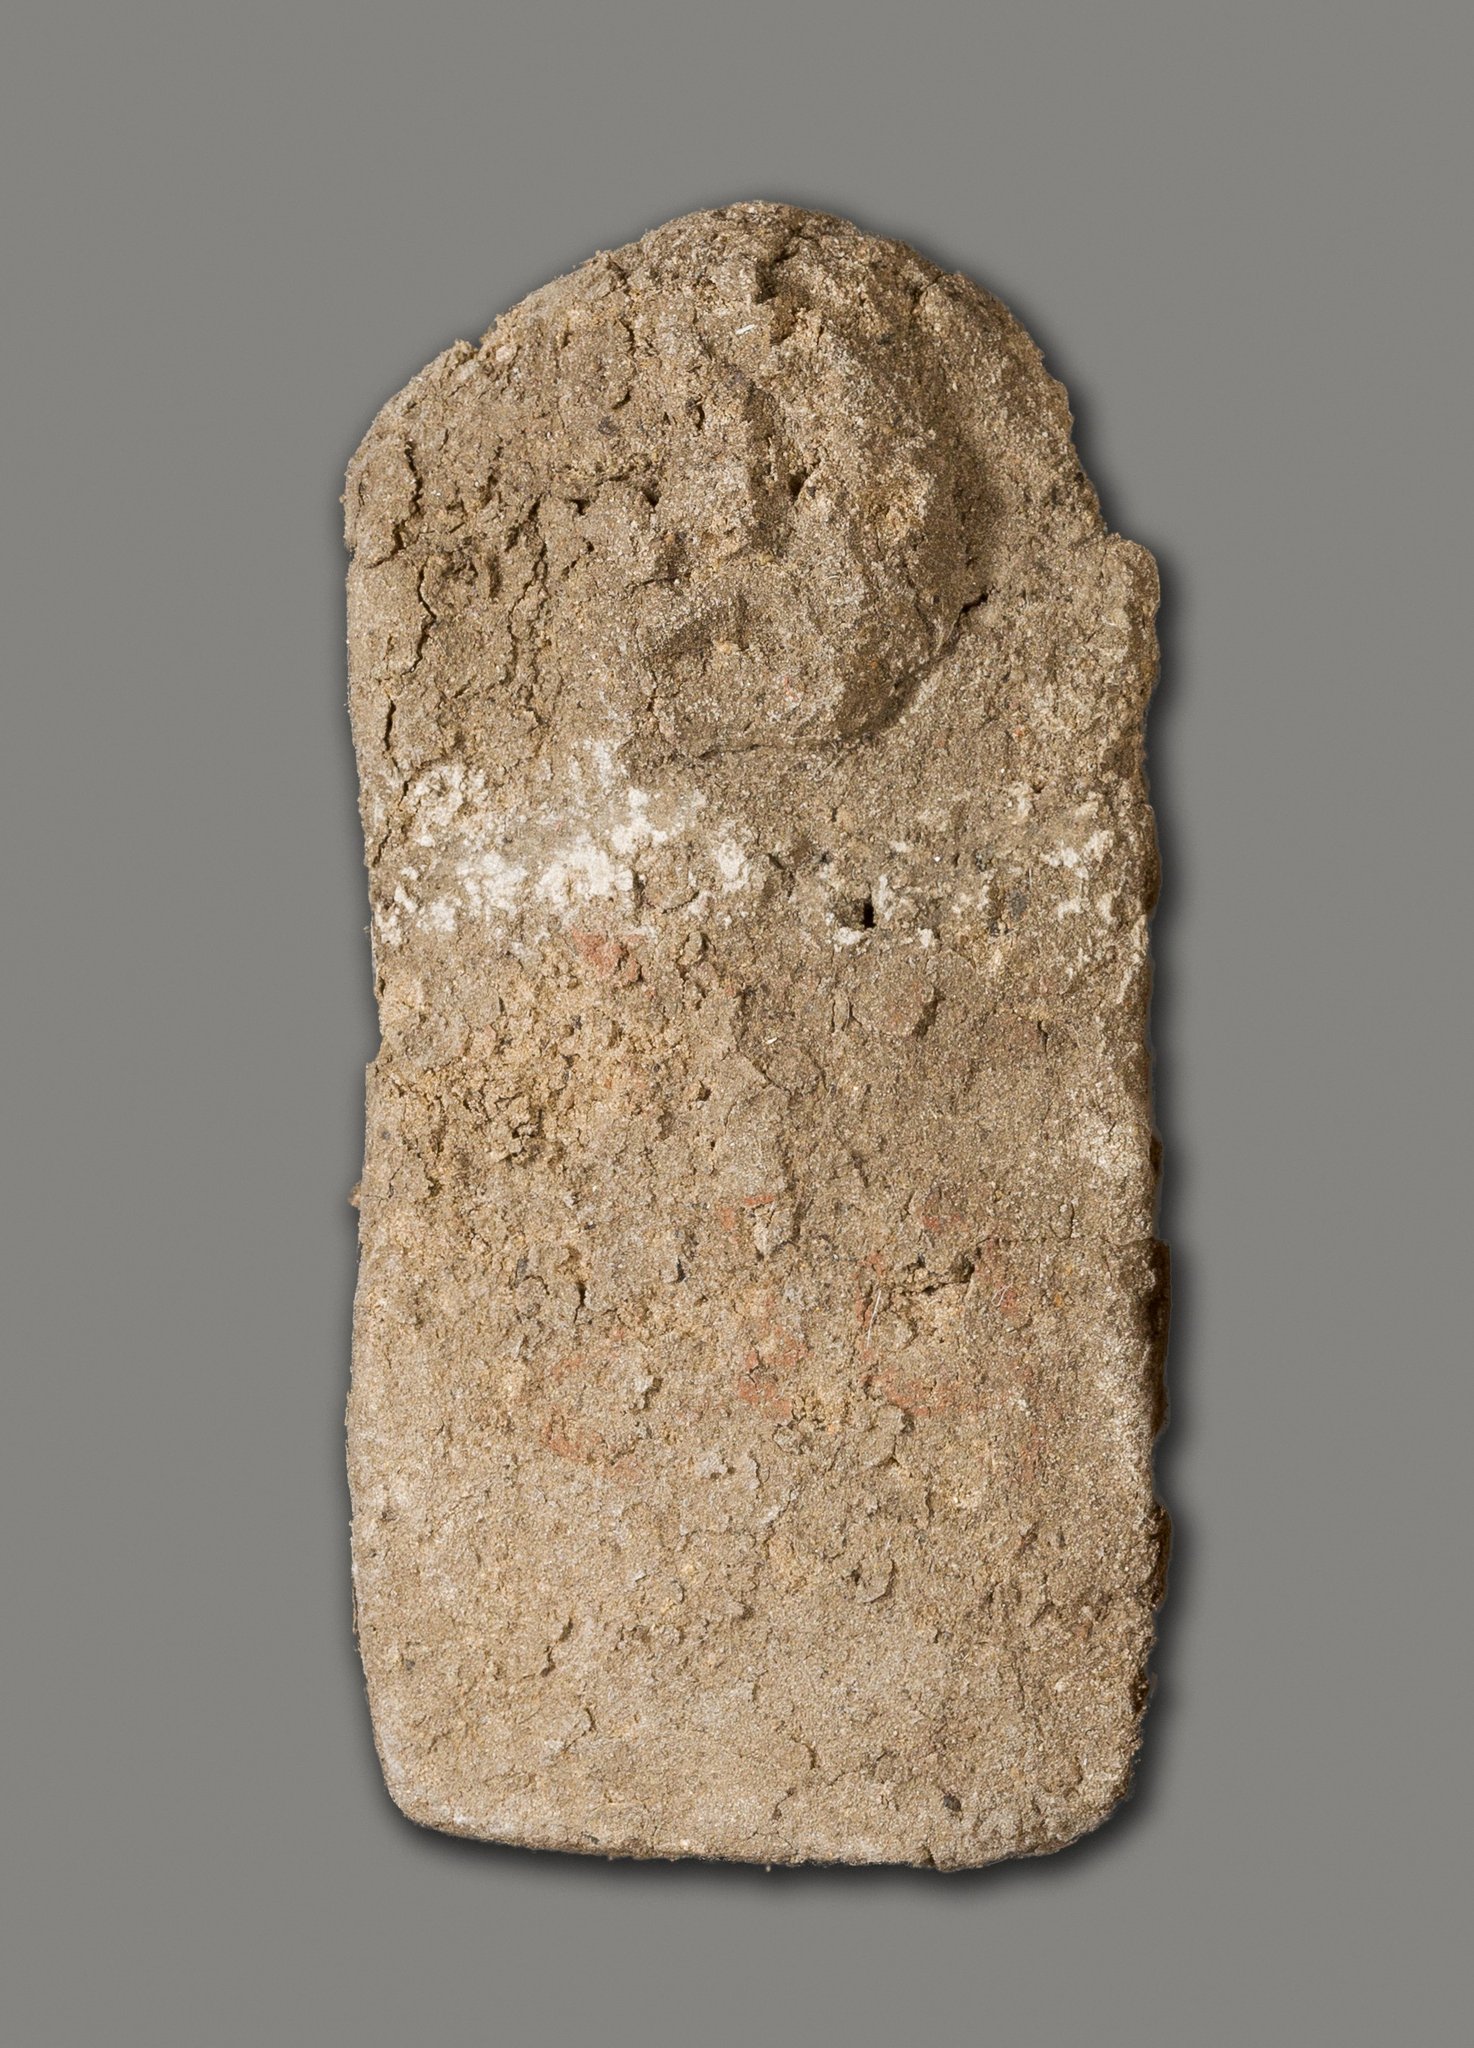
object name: figure, magical, execration, tablet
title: Magical Figure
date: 1802-1550 BCE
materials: clay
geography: egypt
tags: faces